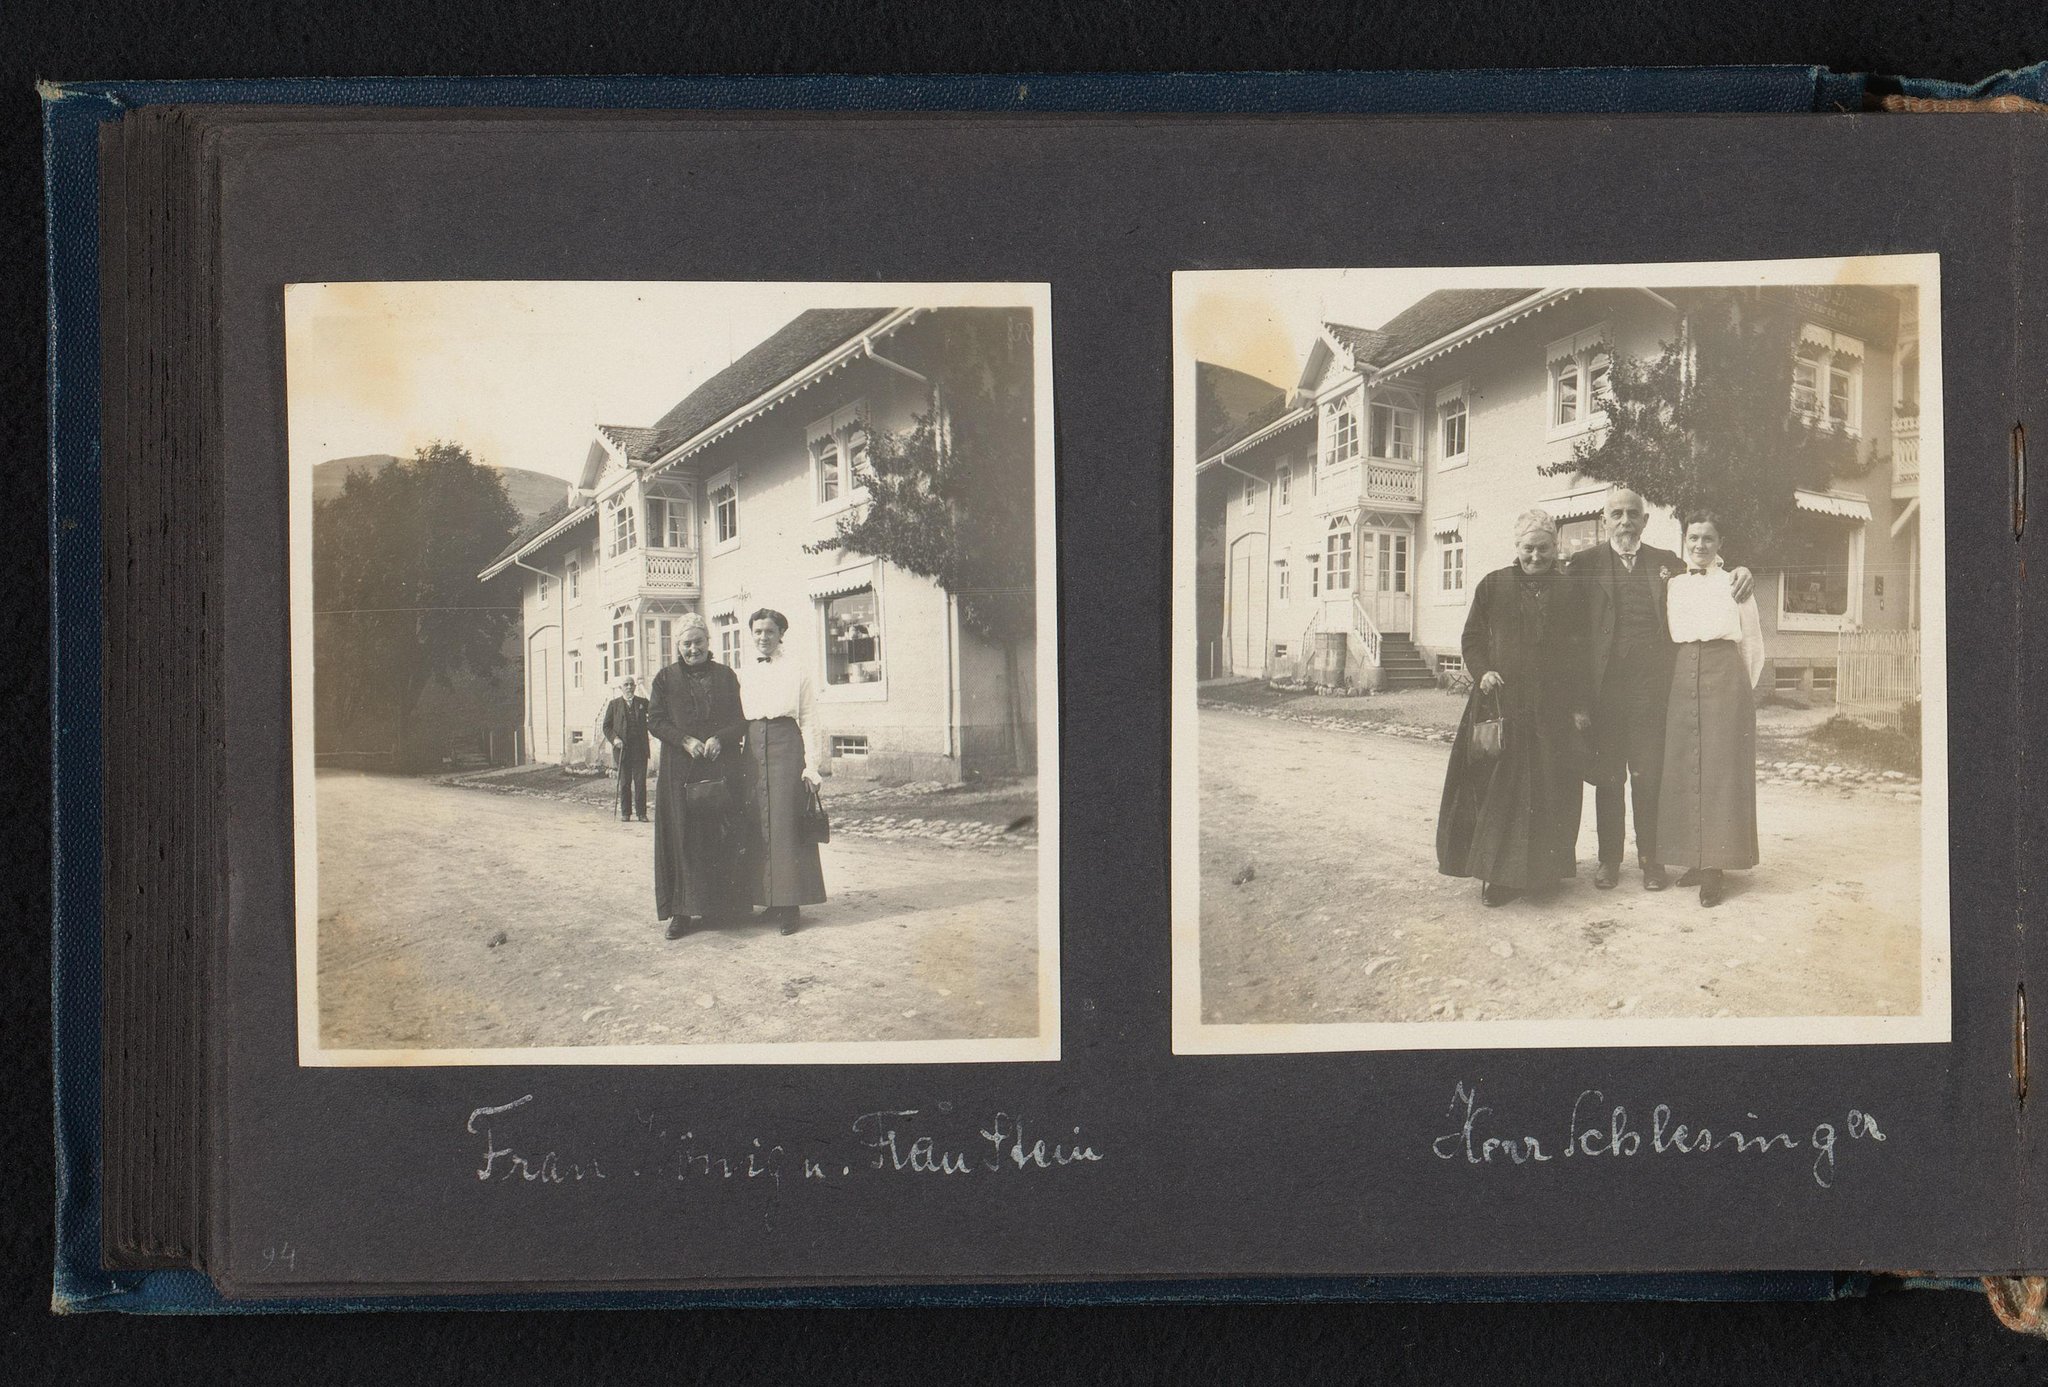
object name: album leaf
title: Vrienden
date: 1916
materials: paper, photographic support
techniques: gelatin silver print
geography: germany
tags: else wachenheimer-moos, germany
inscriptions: inscription: ‘Frau König u. Frau Stein / Herr Schlesinger’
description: Albumblad met twee foto's van bevriende families. Onderdeel van het fotoalbum van Else Wachenheimer-Moos en haar broers Arthur en Willy Moos en anderen in de periode 1913-1918.